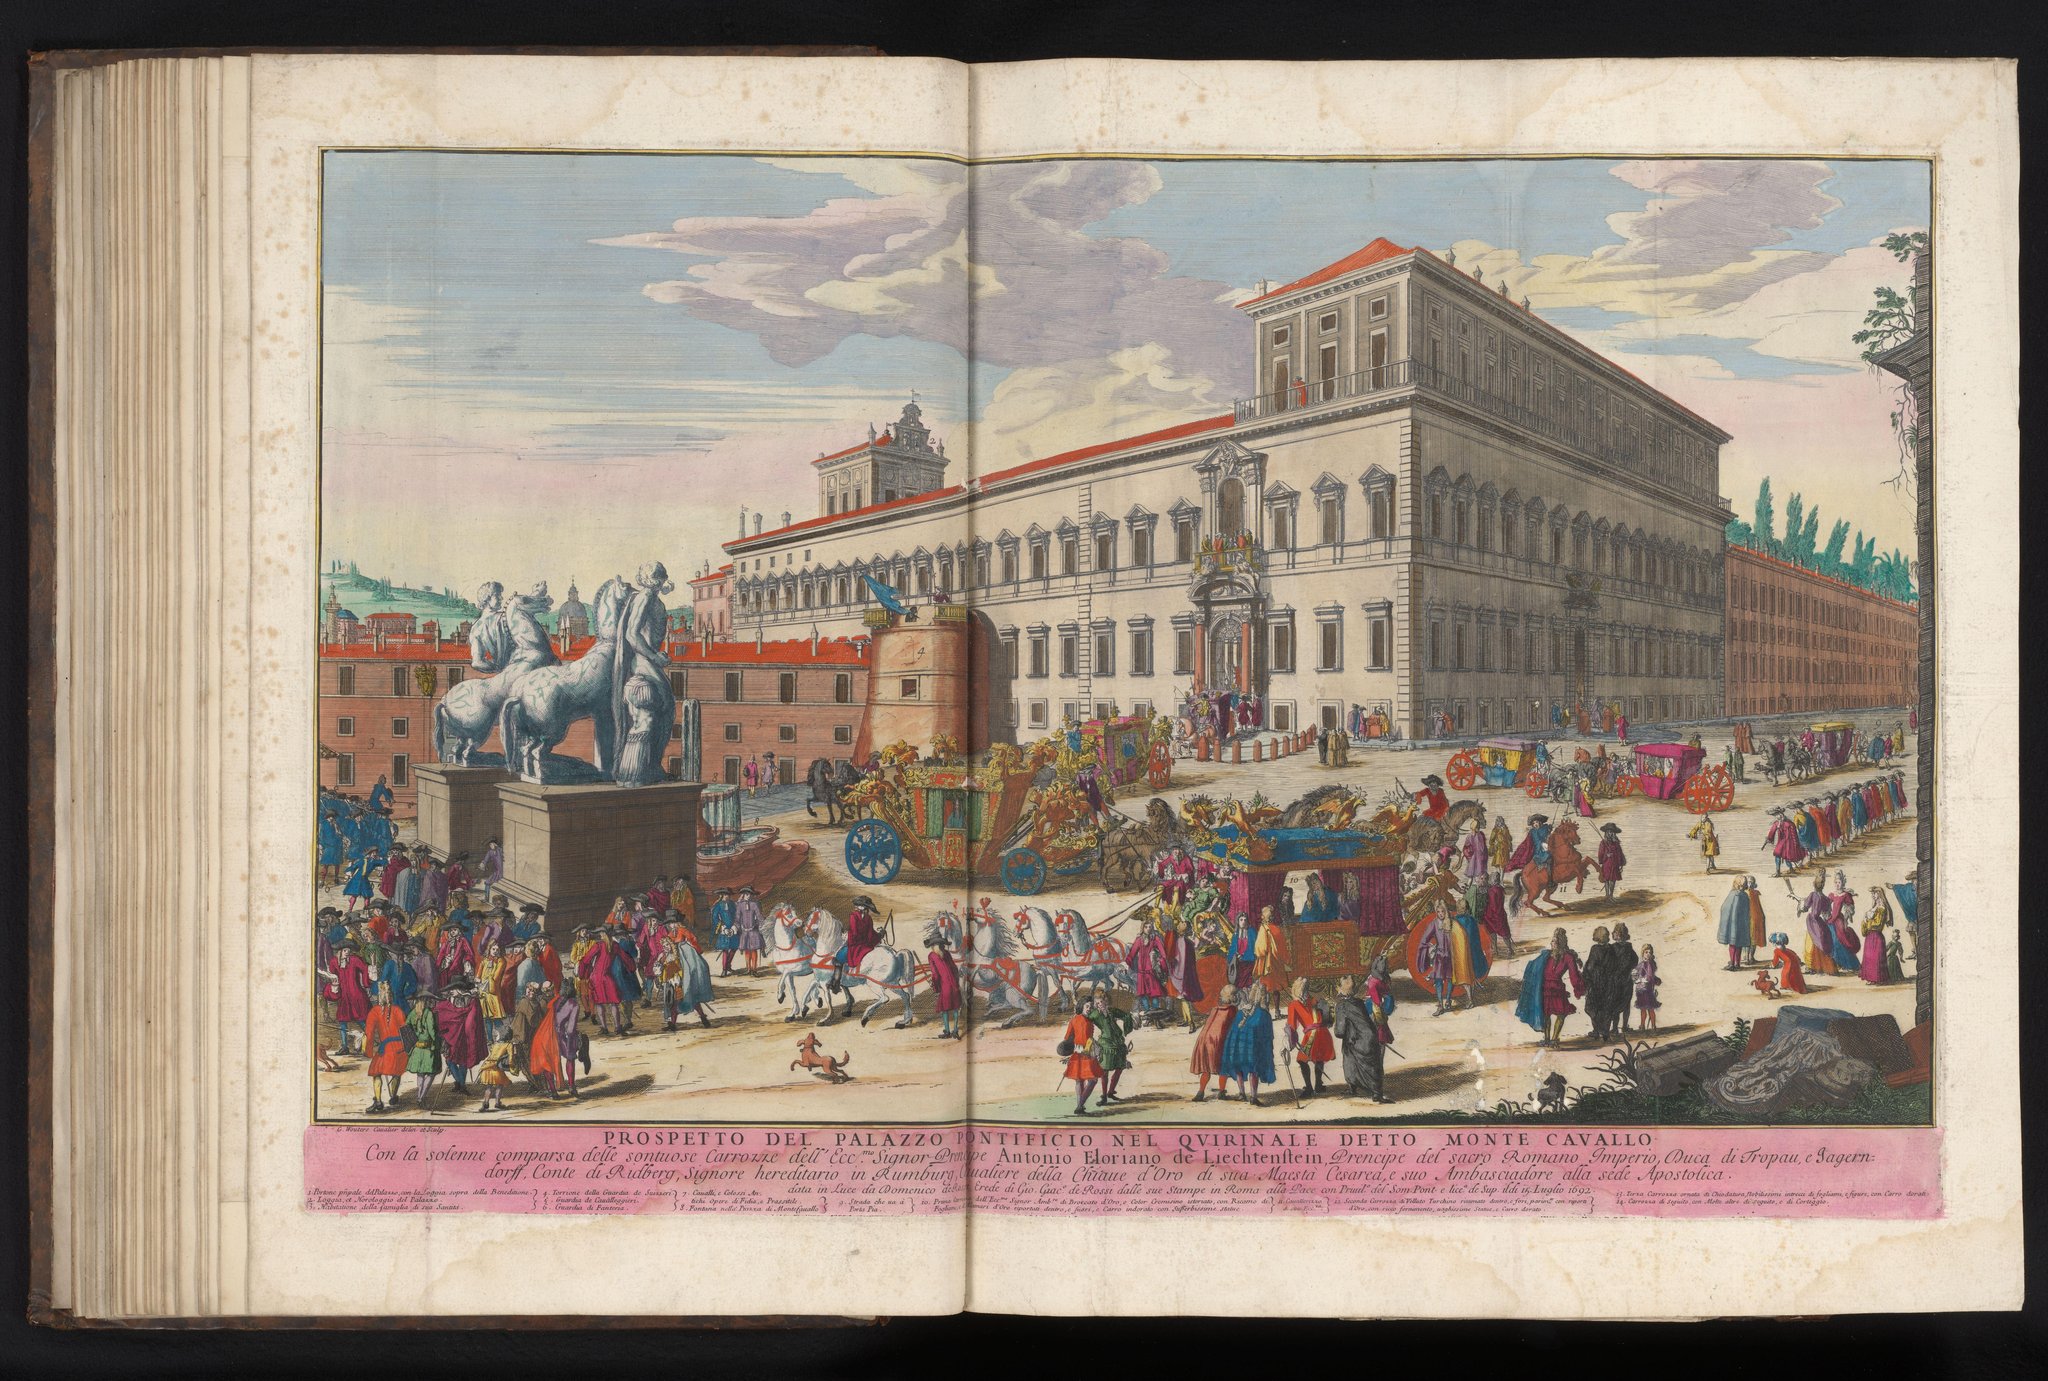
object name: print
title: Prospetto del Palazzo Pontificio nel Quirinale detto Monte Cavallo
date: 1692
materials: paper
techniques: colour, etching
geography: rome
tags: square, place, circus, etc., one of the dioscuri: pollux, the boxer, one of the dioscuri: castor, the horse-tamer, piece of sculpture, reproduction of a piece of sculpture, ornamental fountain, hôtel, i.e. small palace in city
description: Gezicht op het Piazza del Quirinale op de Quirinaalheuvel te Rome met het Palazzo del Quirinale en de Fontana di Monte Cavallo (fontein met Castor en Pollux). In de ondermarge de titel, opdracht en een verklarende lijst met nummers. Prent maakt deel uit van een album.